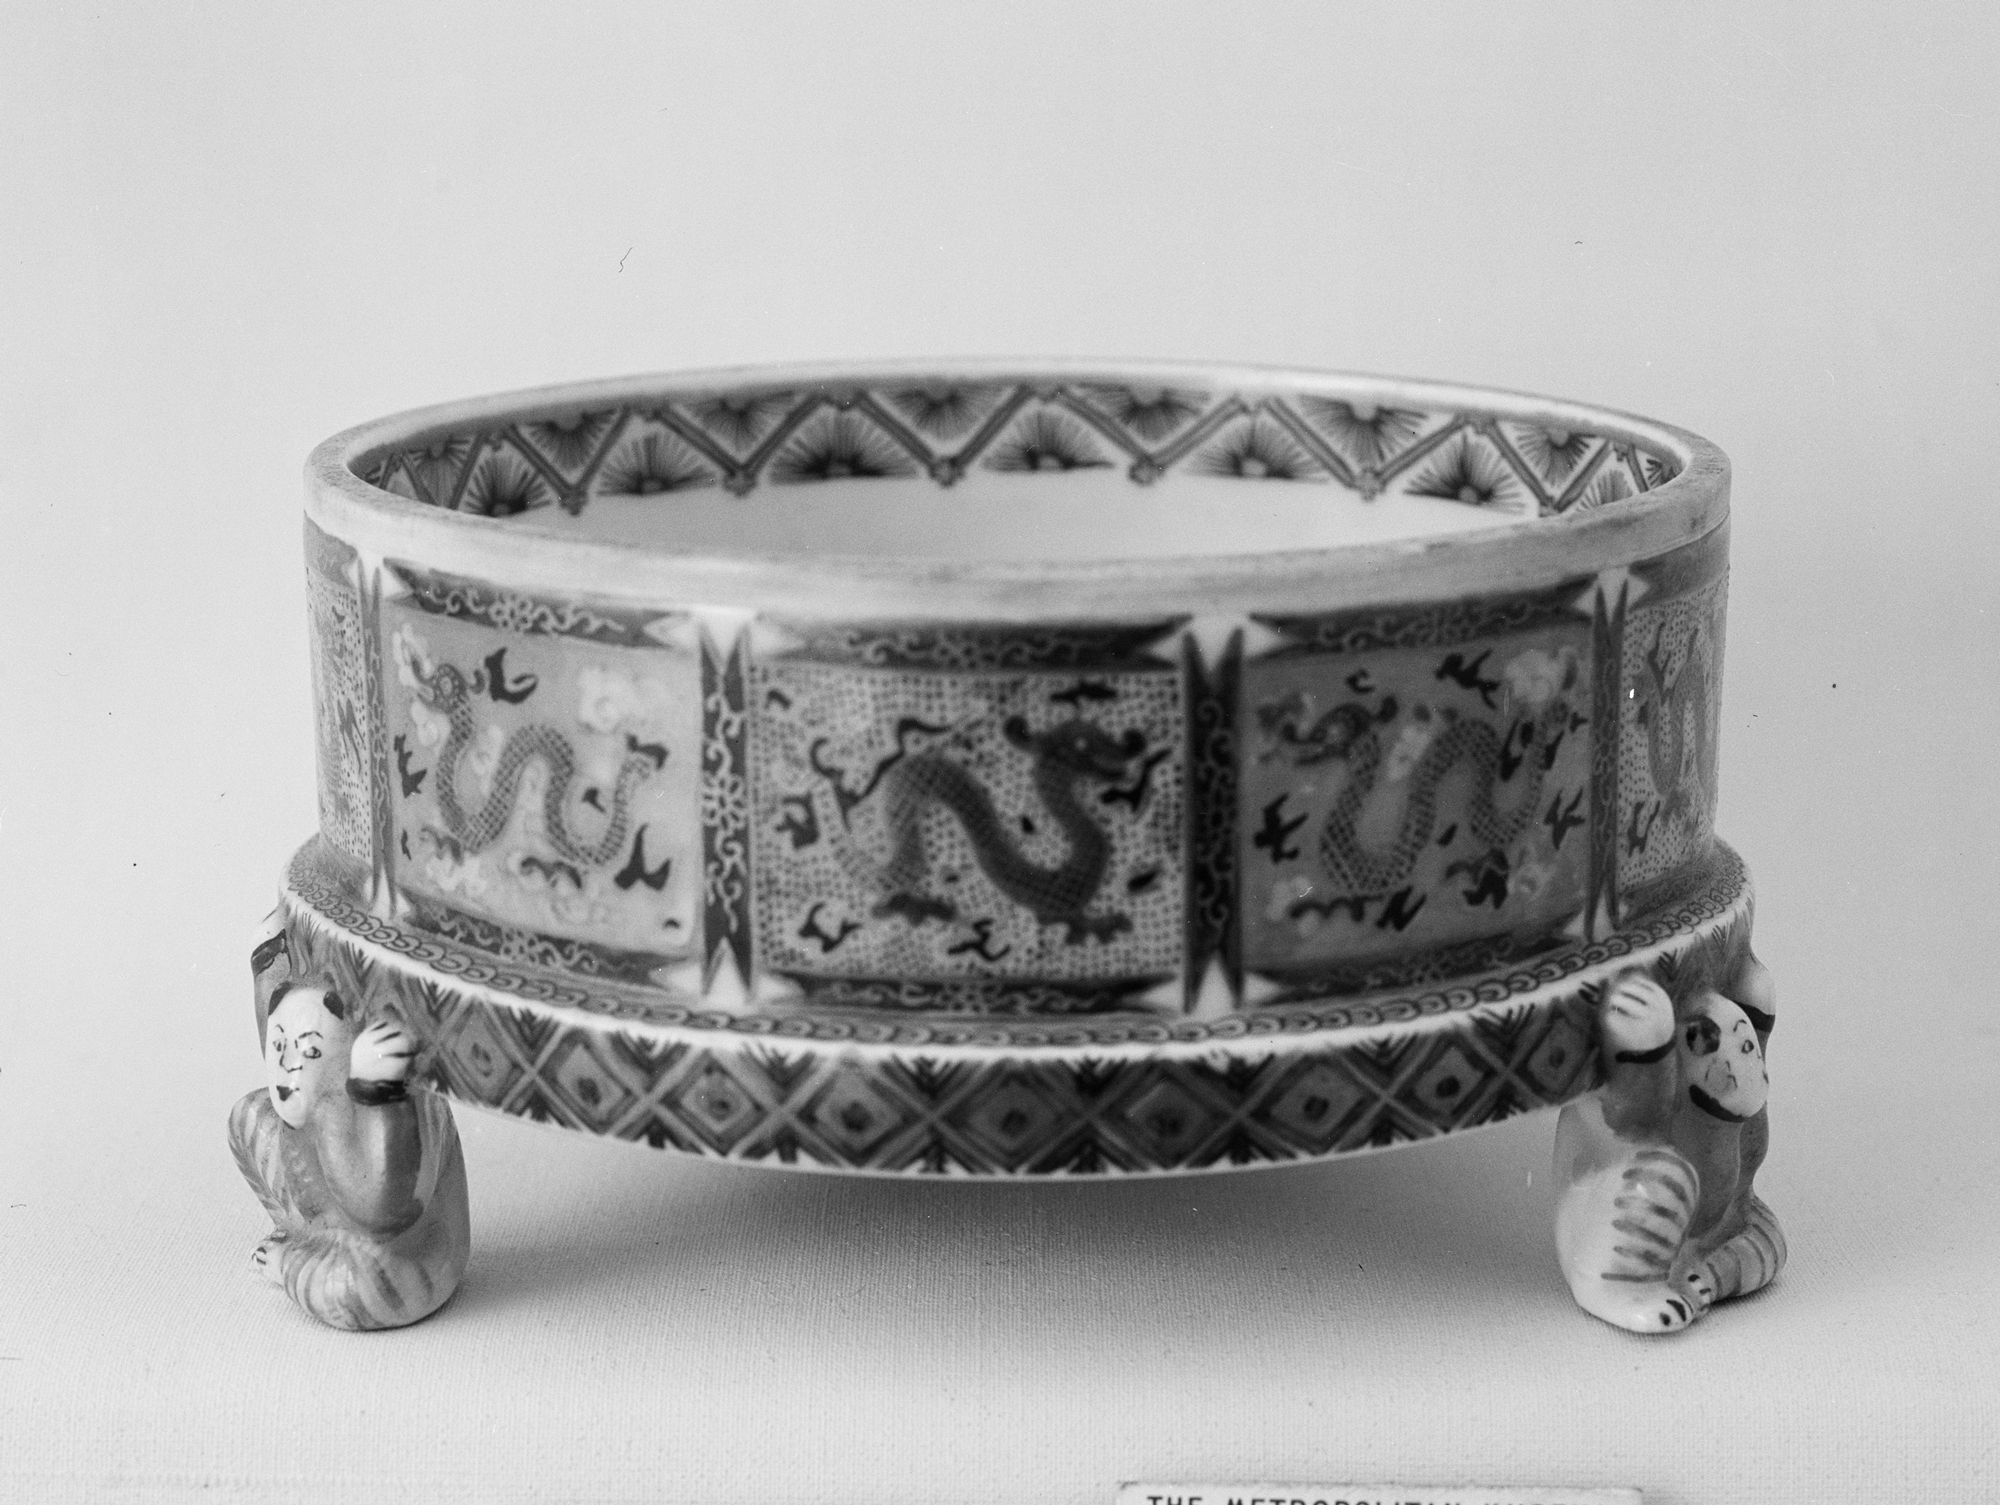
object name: box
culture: japanese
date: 1701-1800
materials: porcelain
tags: human figures,dragons